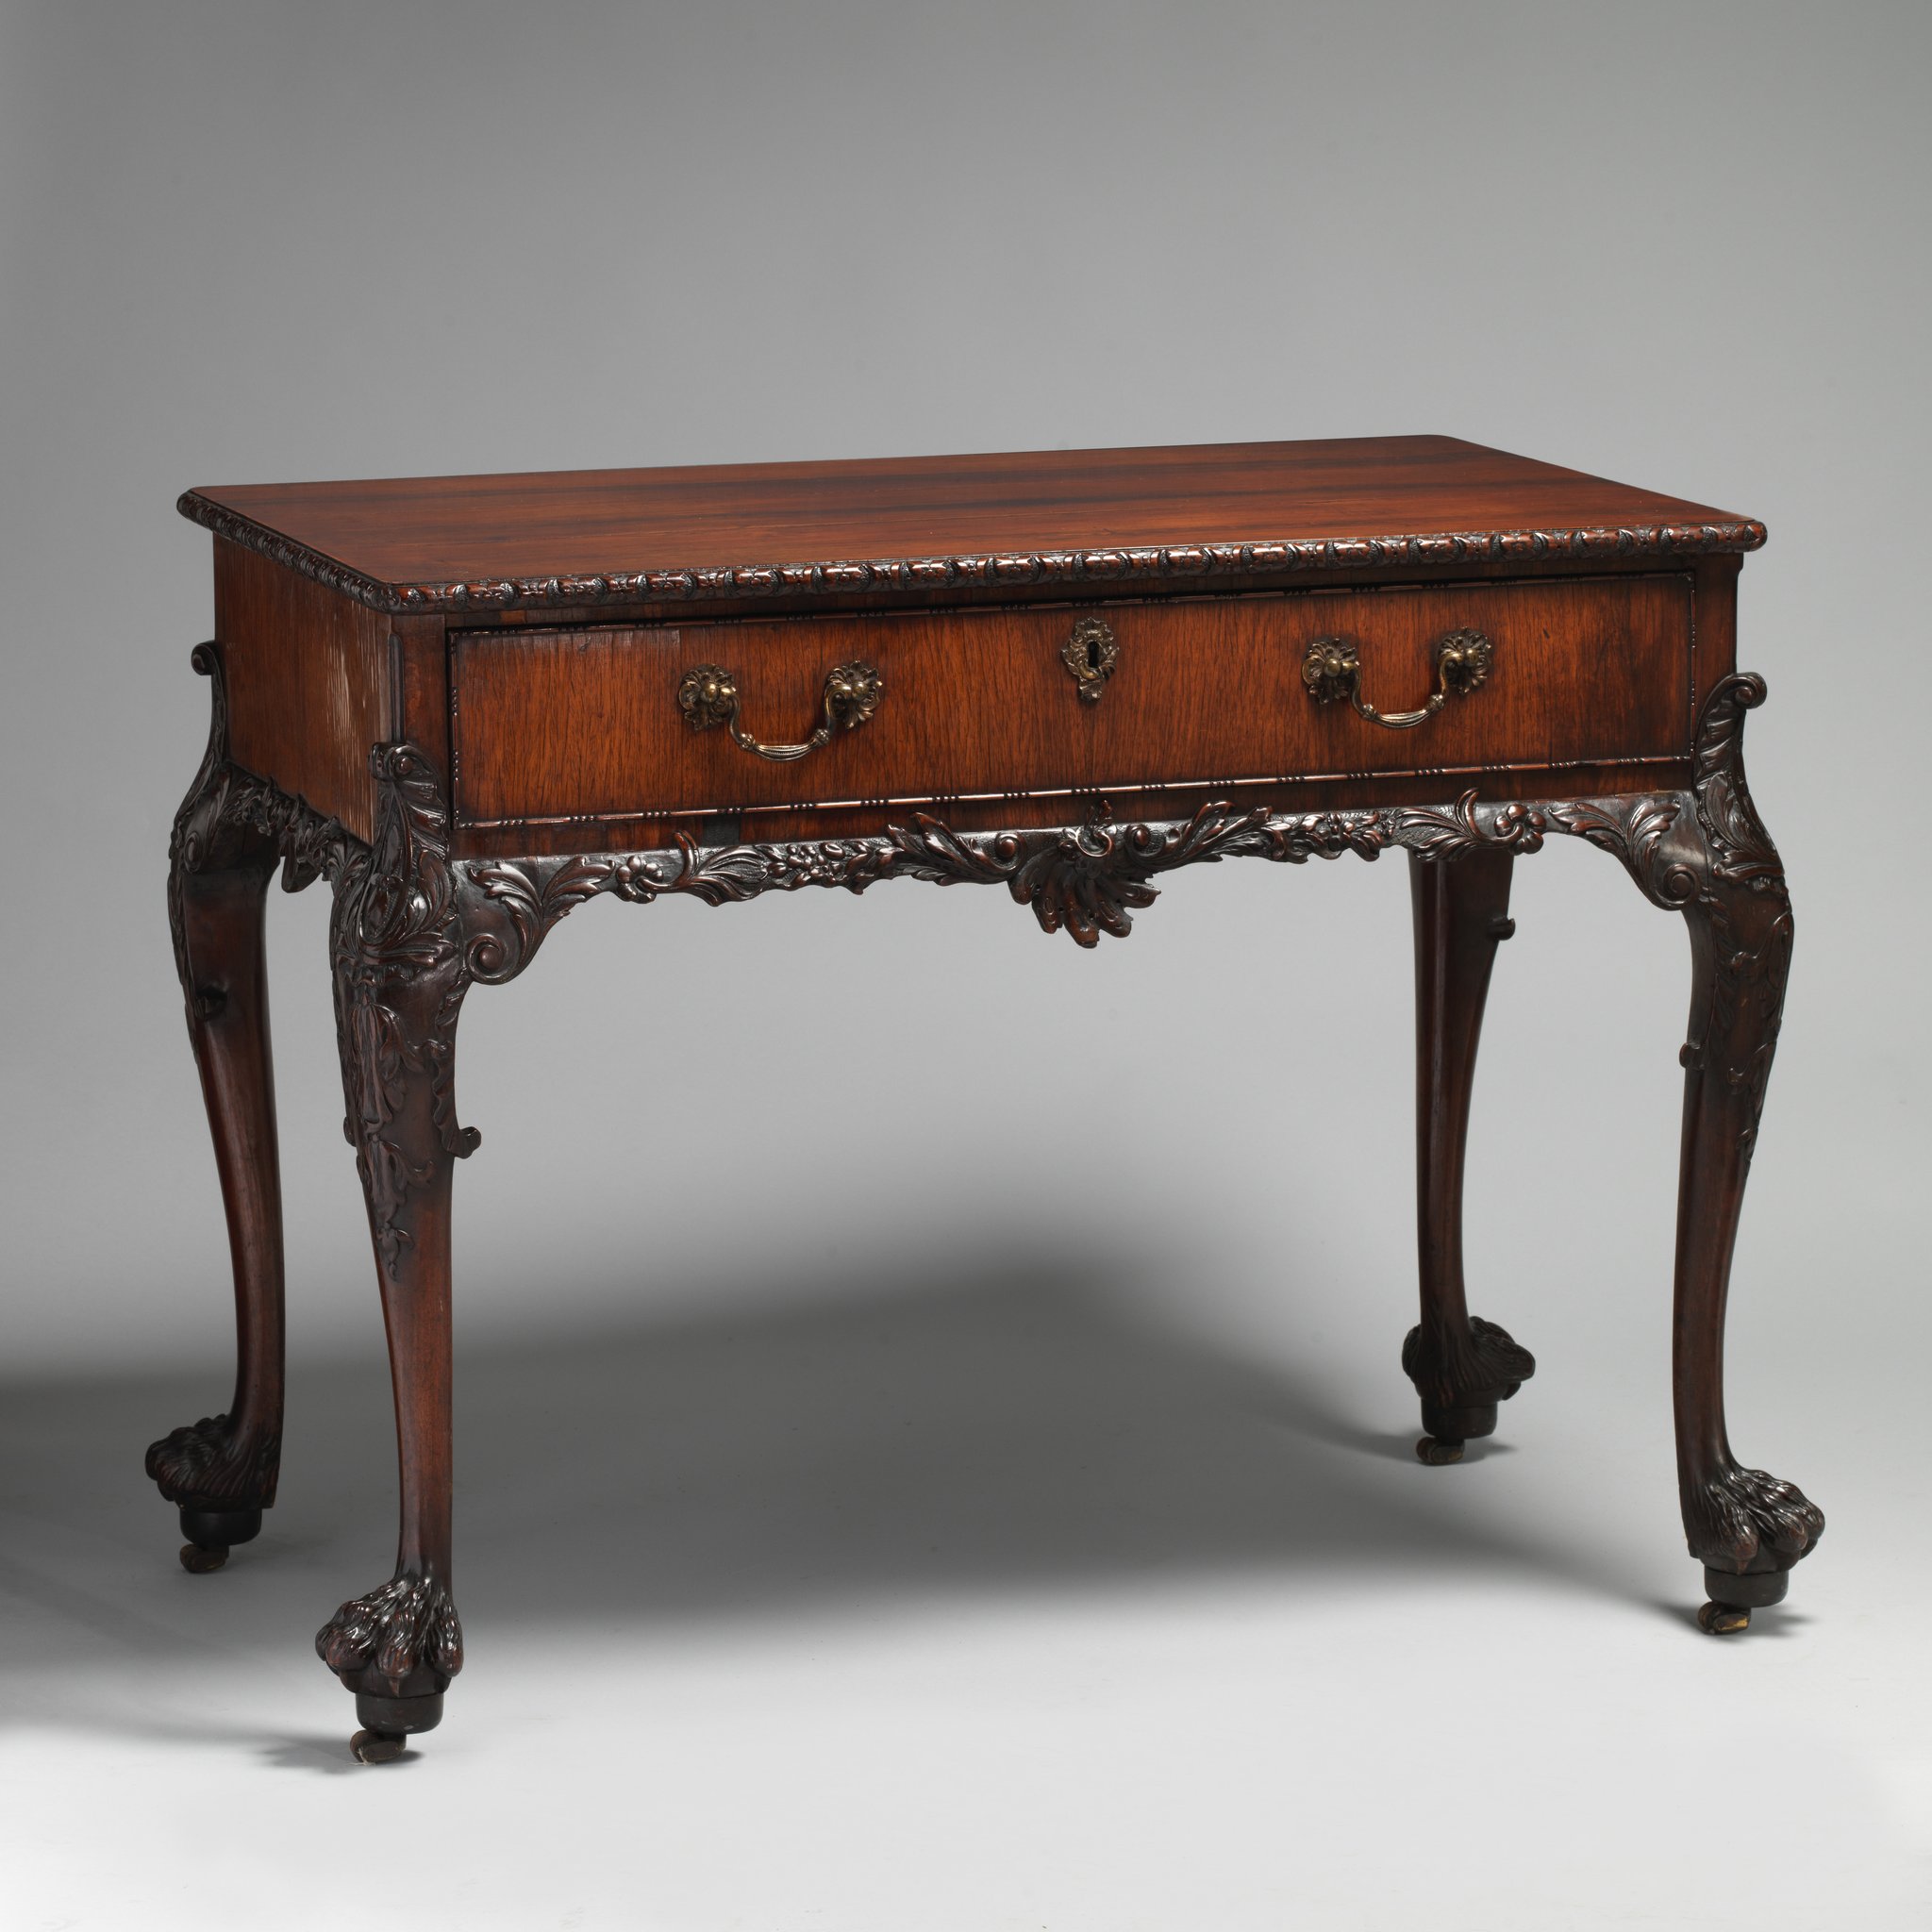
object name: table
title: Pair of tables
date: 1750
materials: wood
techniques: veneering